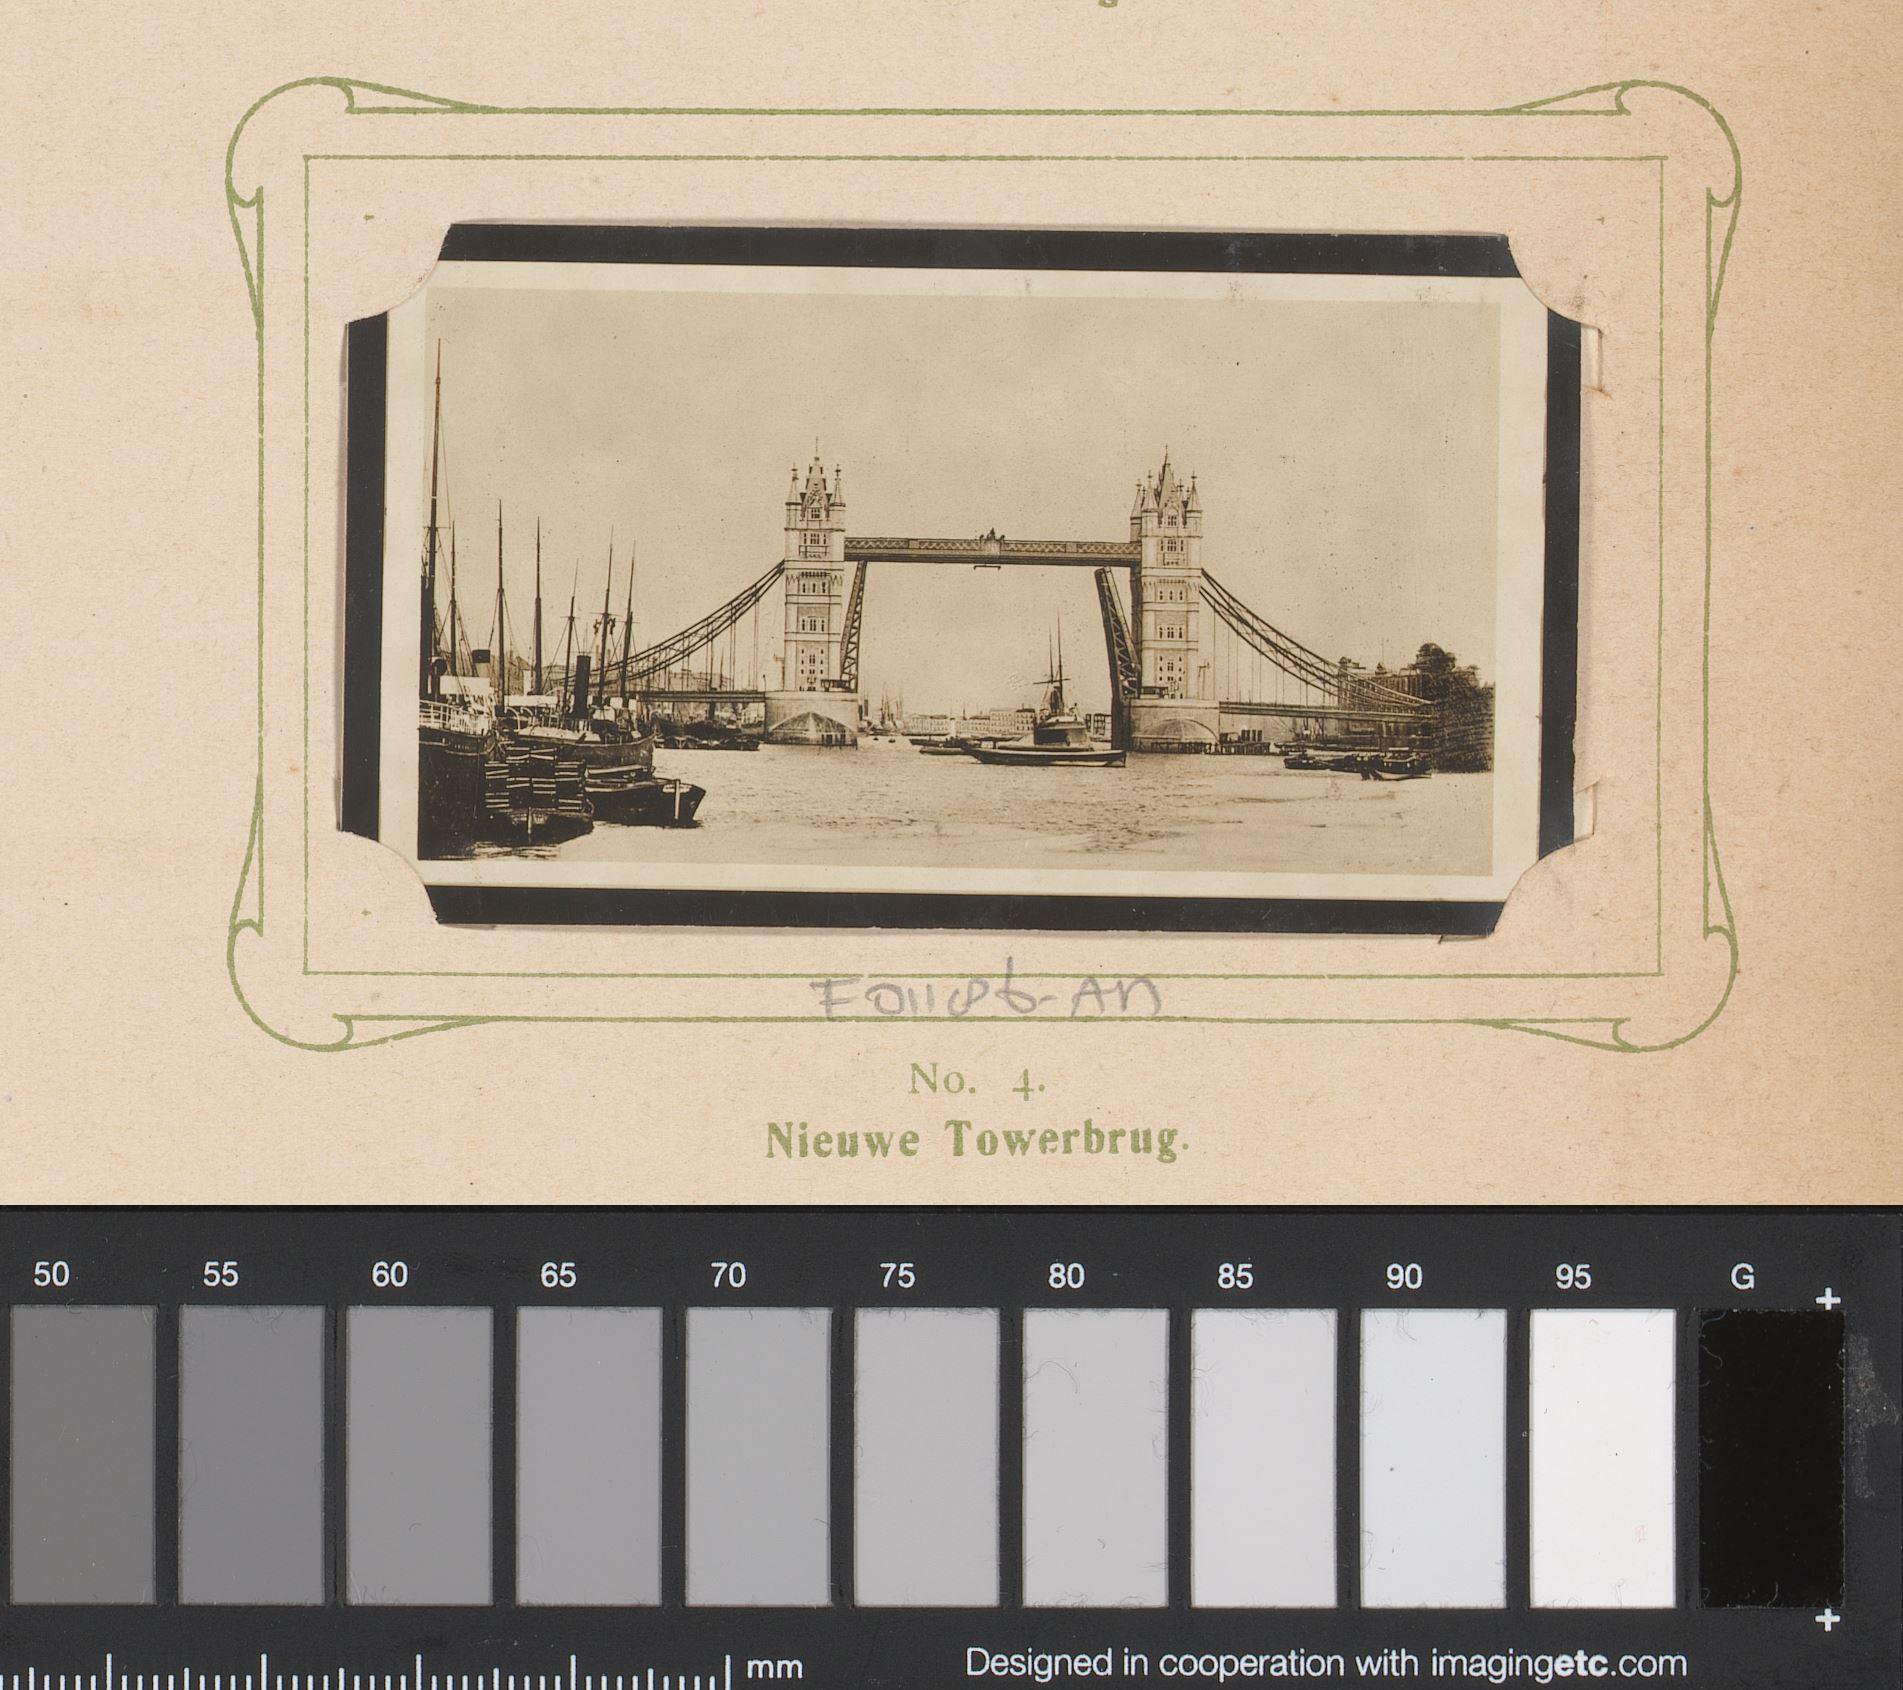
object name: photograph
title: Gezicht op de Tower Bridge te Londen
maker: Anonymous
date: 1904-1905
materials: photographic support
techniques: gelatin silver print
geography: london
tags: bridge in city across river, canal, etc. (+ city(-scape) with figures, staffage), river, thames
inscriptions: inscription: ‘No. 4./ Nieuwe Towerbrug.’